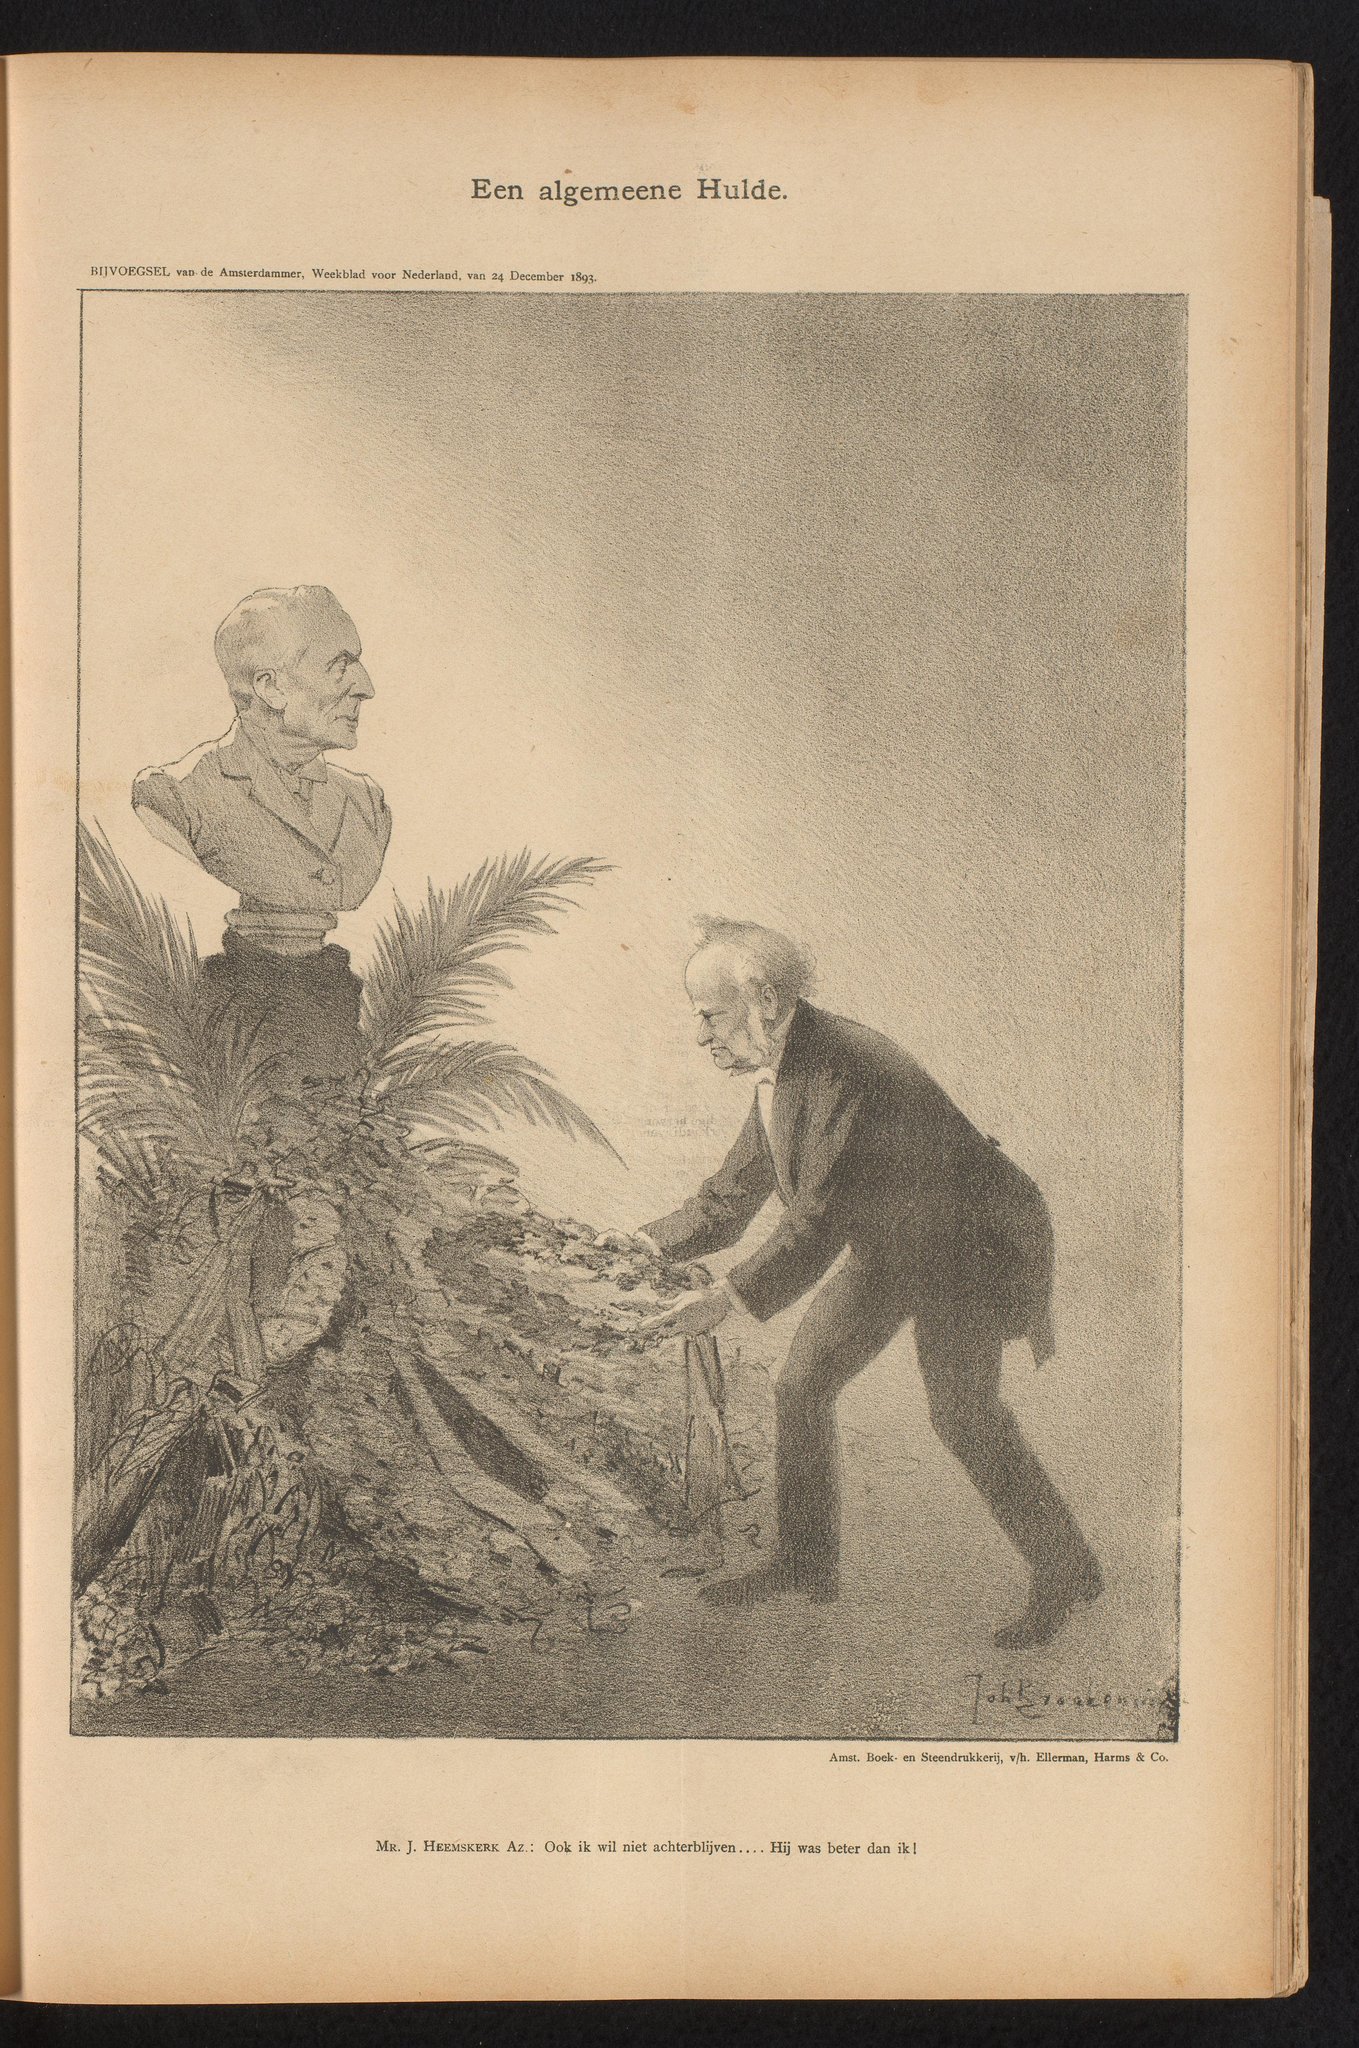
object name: cartoon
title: Een algemeende Hulde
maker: johan braakensiek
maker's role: draughtsman, print maker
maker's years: 1858-1940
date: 1893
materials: paper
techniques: lithograph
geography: netherlands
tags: batavia, the hague, amsterdam, politician, laying flowers or wreath on grave, political caricatures and satires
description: Oud-premier Jan Heemskerk Azn. legt een lauwerkrans bij de buste van politicus en bestuurder Levinus Keuchenius, die overleed op 17 december 1893.